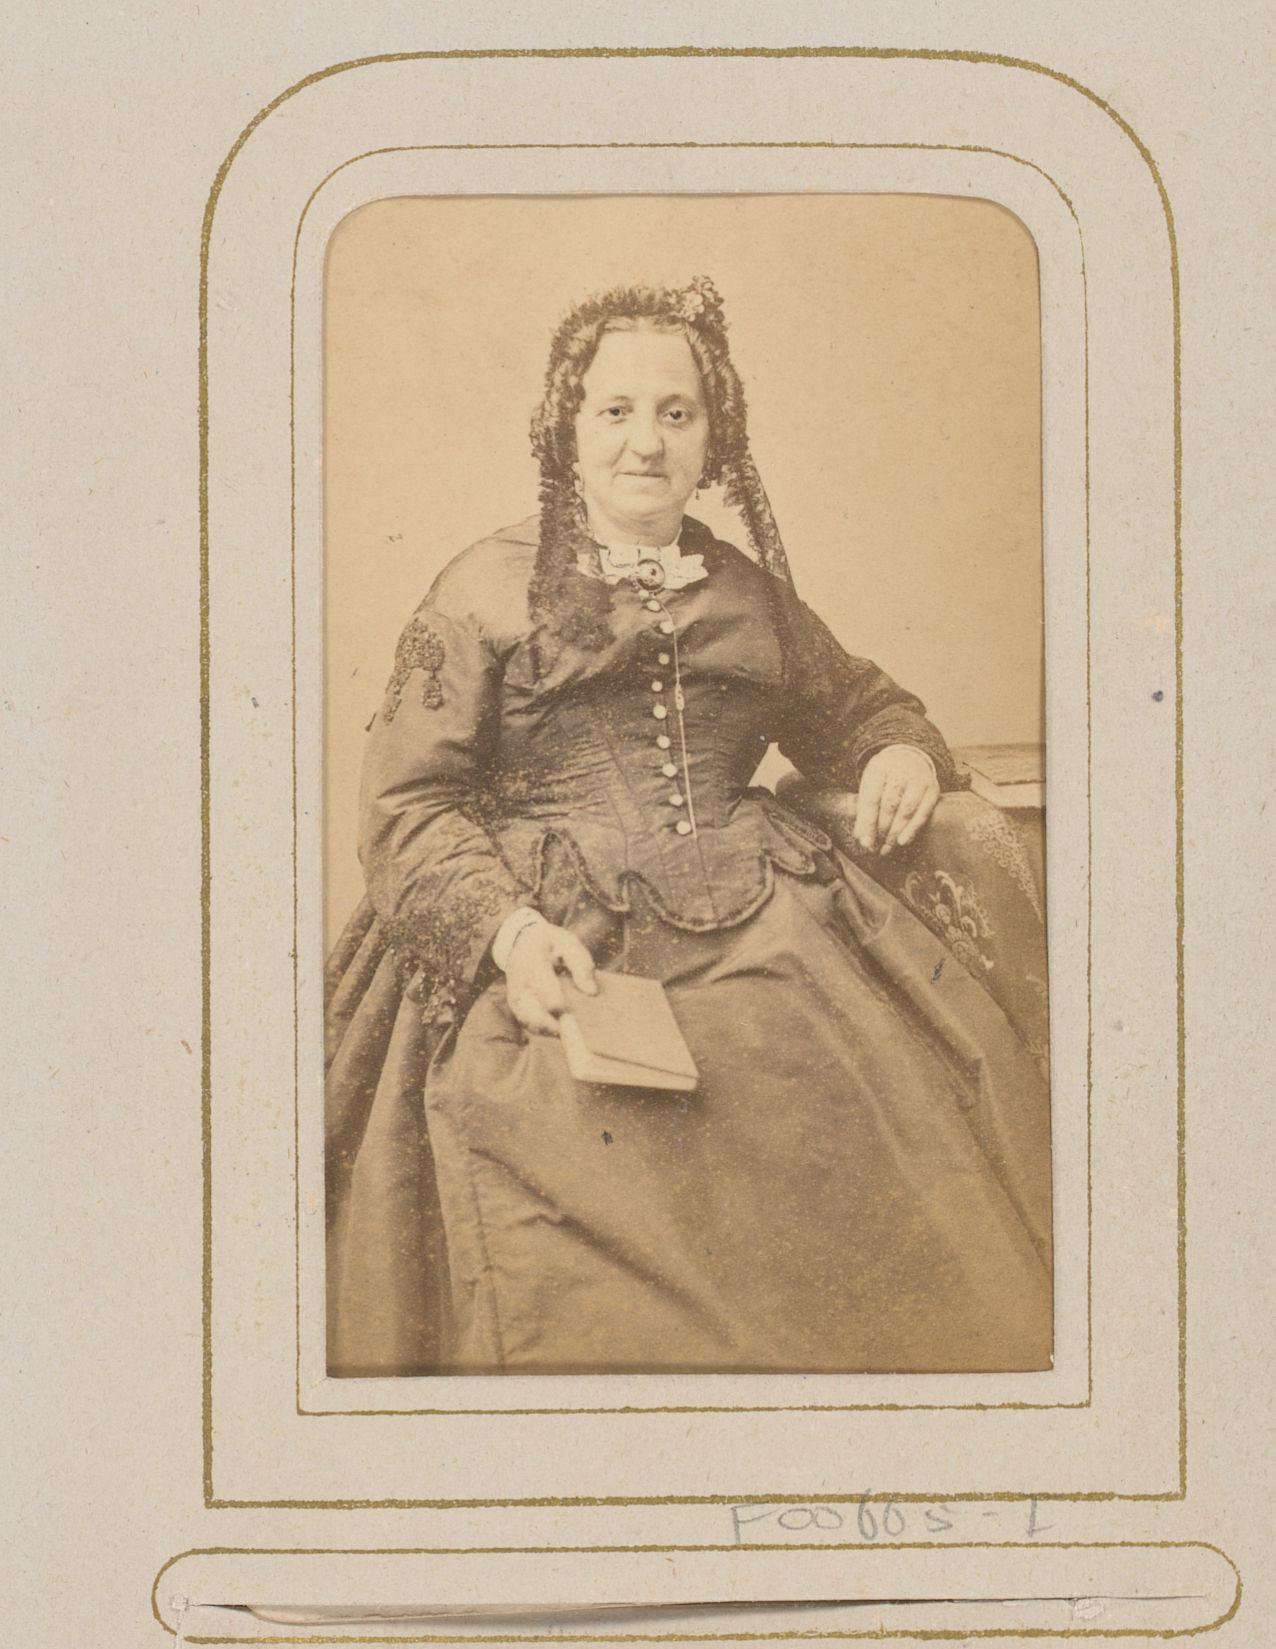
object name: album leaf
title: Portret van een oude vrouw met boek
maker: pieter voet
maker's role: goldsmith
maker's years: 1831-1907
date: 1865-1881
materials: cardboard, photographic support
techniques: albumen print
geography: haarlem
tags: historical persons - bb - woman, old woman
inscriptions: inscription: ‘Photographisch Atelier/ P. Voet/ Klein Heiligenland 484/ Haarlem’